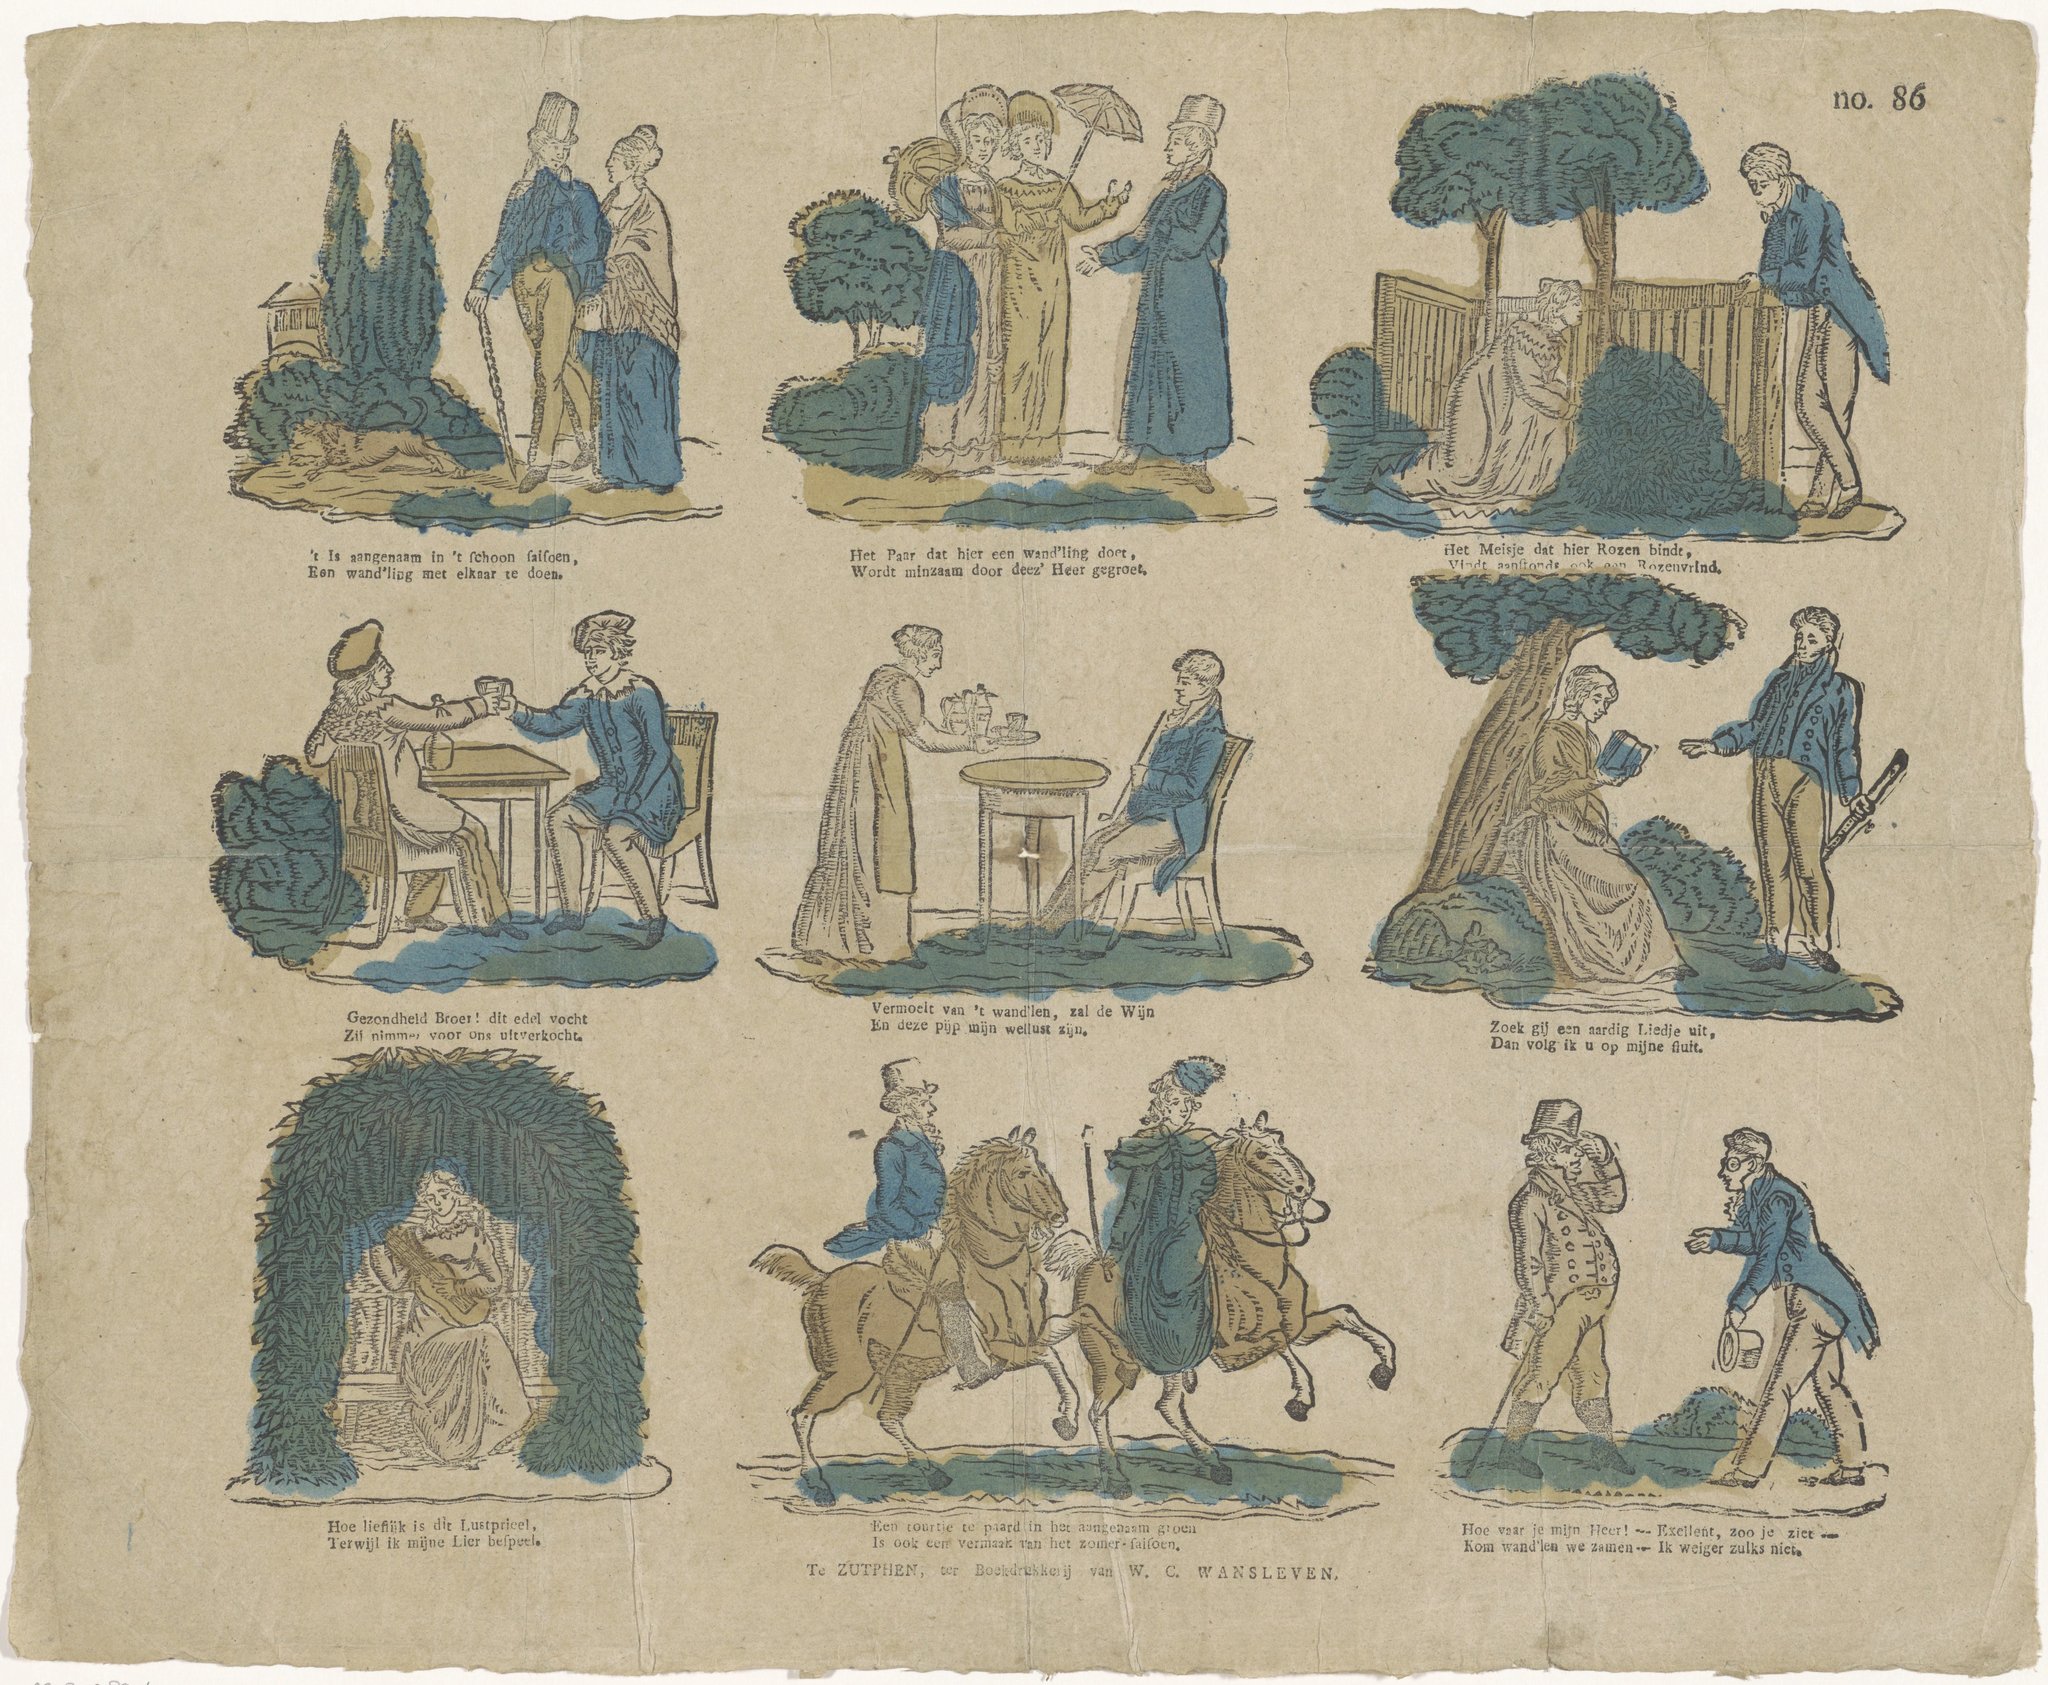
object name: print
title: Allerlei bezigheden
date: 1806-1858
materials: paper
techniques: colour, letterpress printing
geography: netherlands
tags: riding a horse, ass, or mule; rider, horseman, musician at work, walking, hiking (recreation), drinking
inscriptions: collector's mark: Lugt 2760, collector's mark: Lugt 2228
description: Blad met 9 voorstellingen van verschillende bezigheden, waaronder wandelen, drinken en de lier bespelen. Onder elke afbeelding een tweeregelig vers. Genummerd rechtsboven: no. 86.